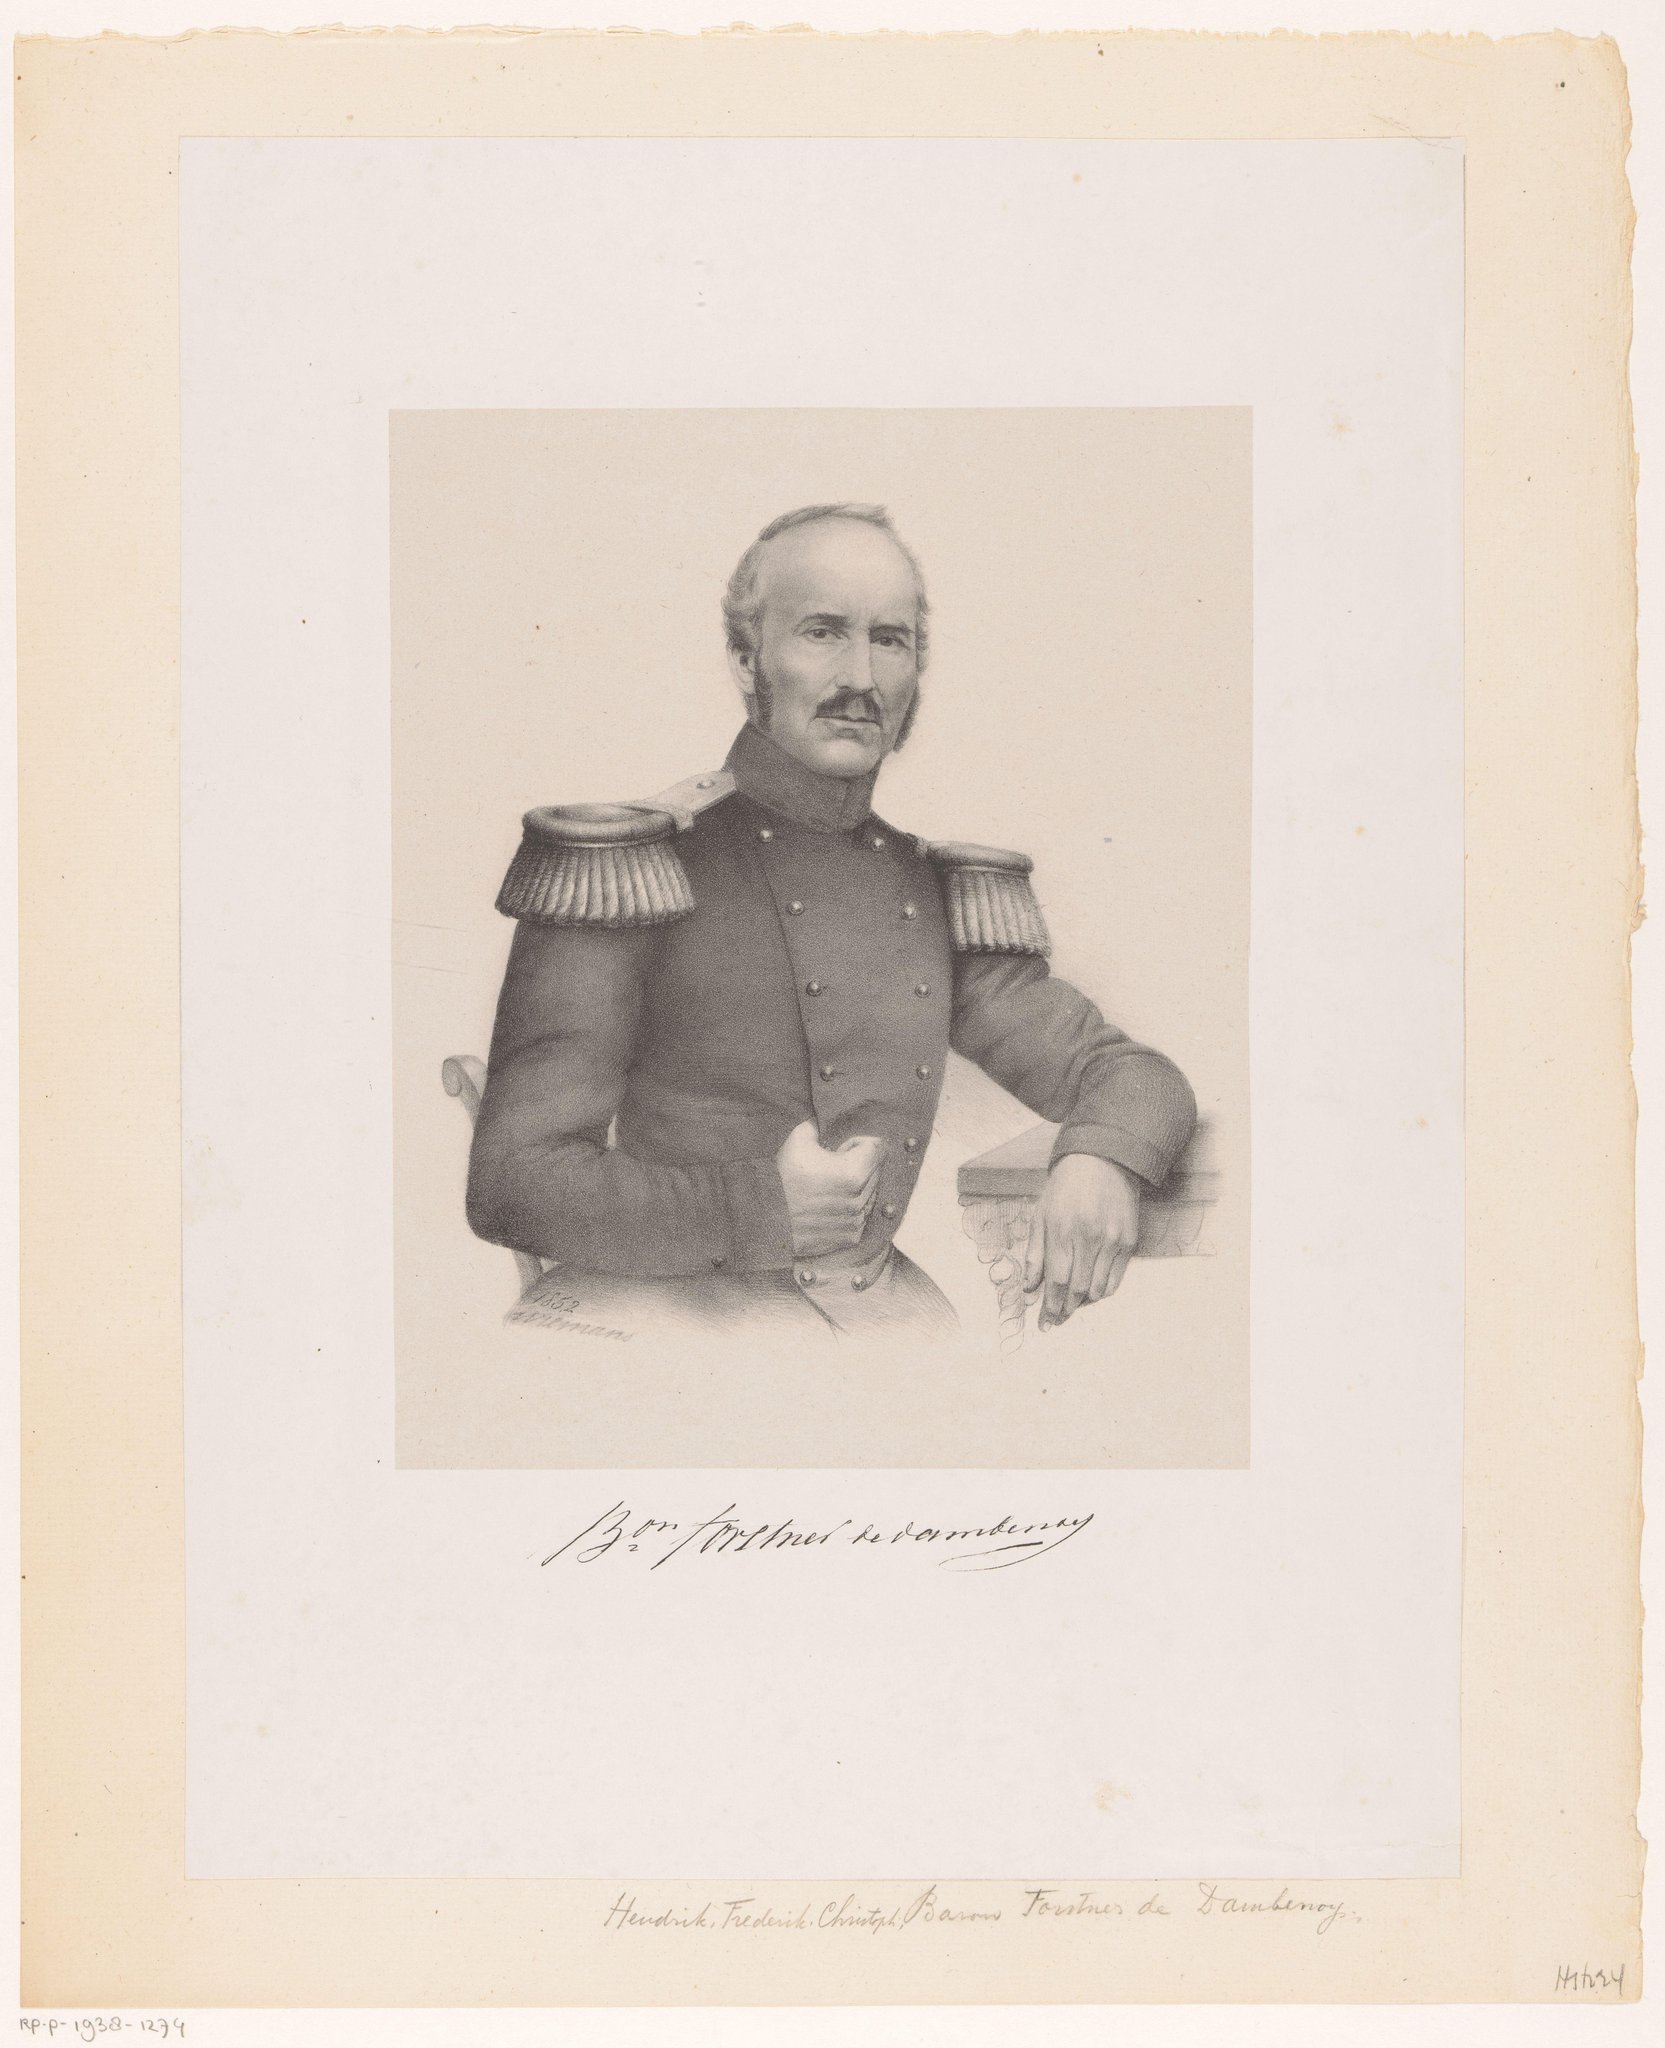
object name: print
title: Portret van Hendrik Frederik Christoph Forstner van Dambenoy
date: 1852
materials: paper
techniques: lithograph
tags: maastricht, utrecht, historical persons (+ (full) bust portrait)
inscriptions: collector's mark: Lugt 2760, collector's mark: Lugt 2228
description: Onder het portret de signatuur van de geportretteerde.